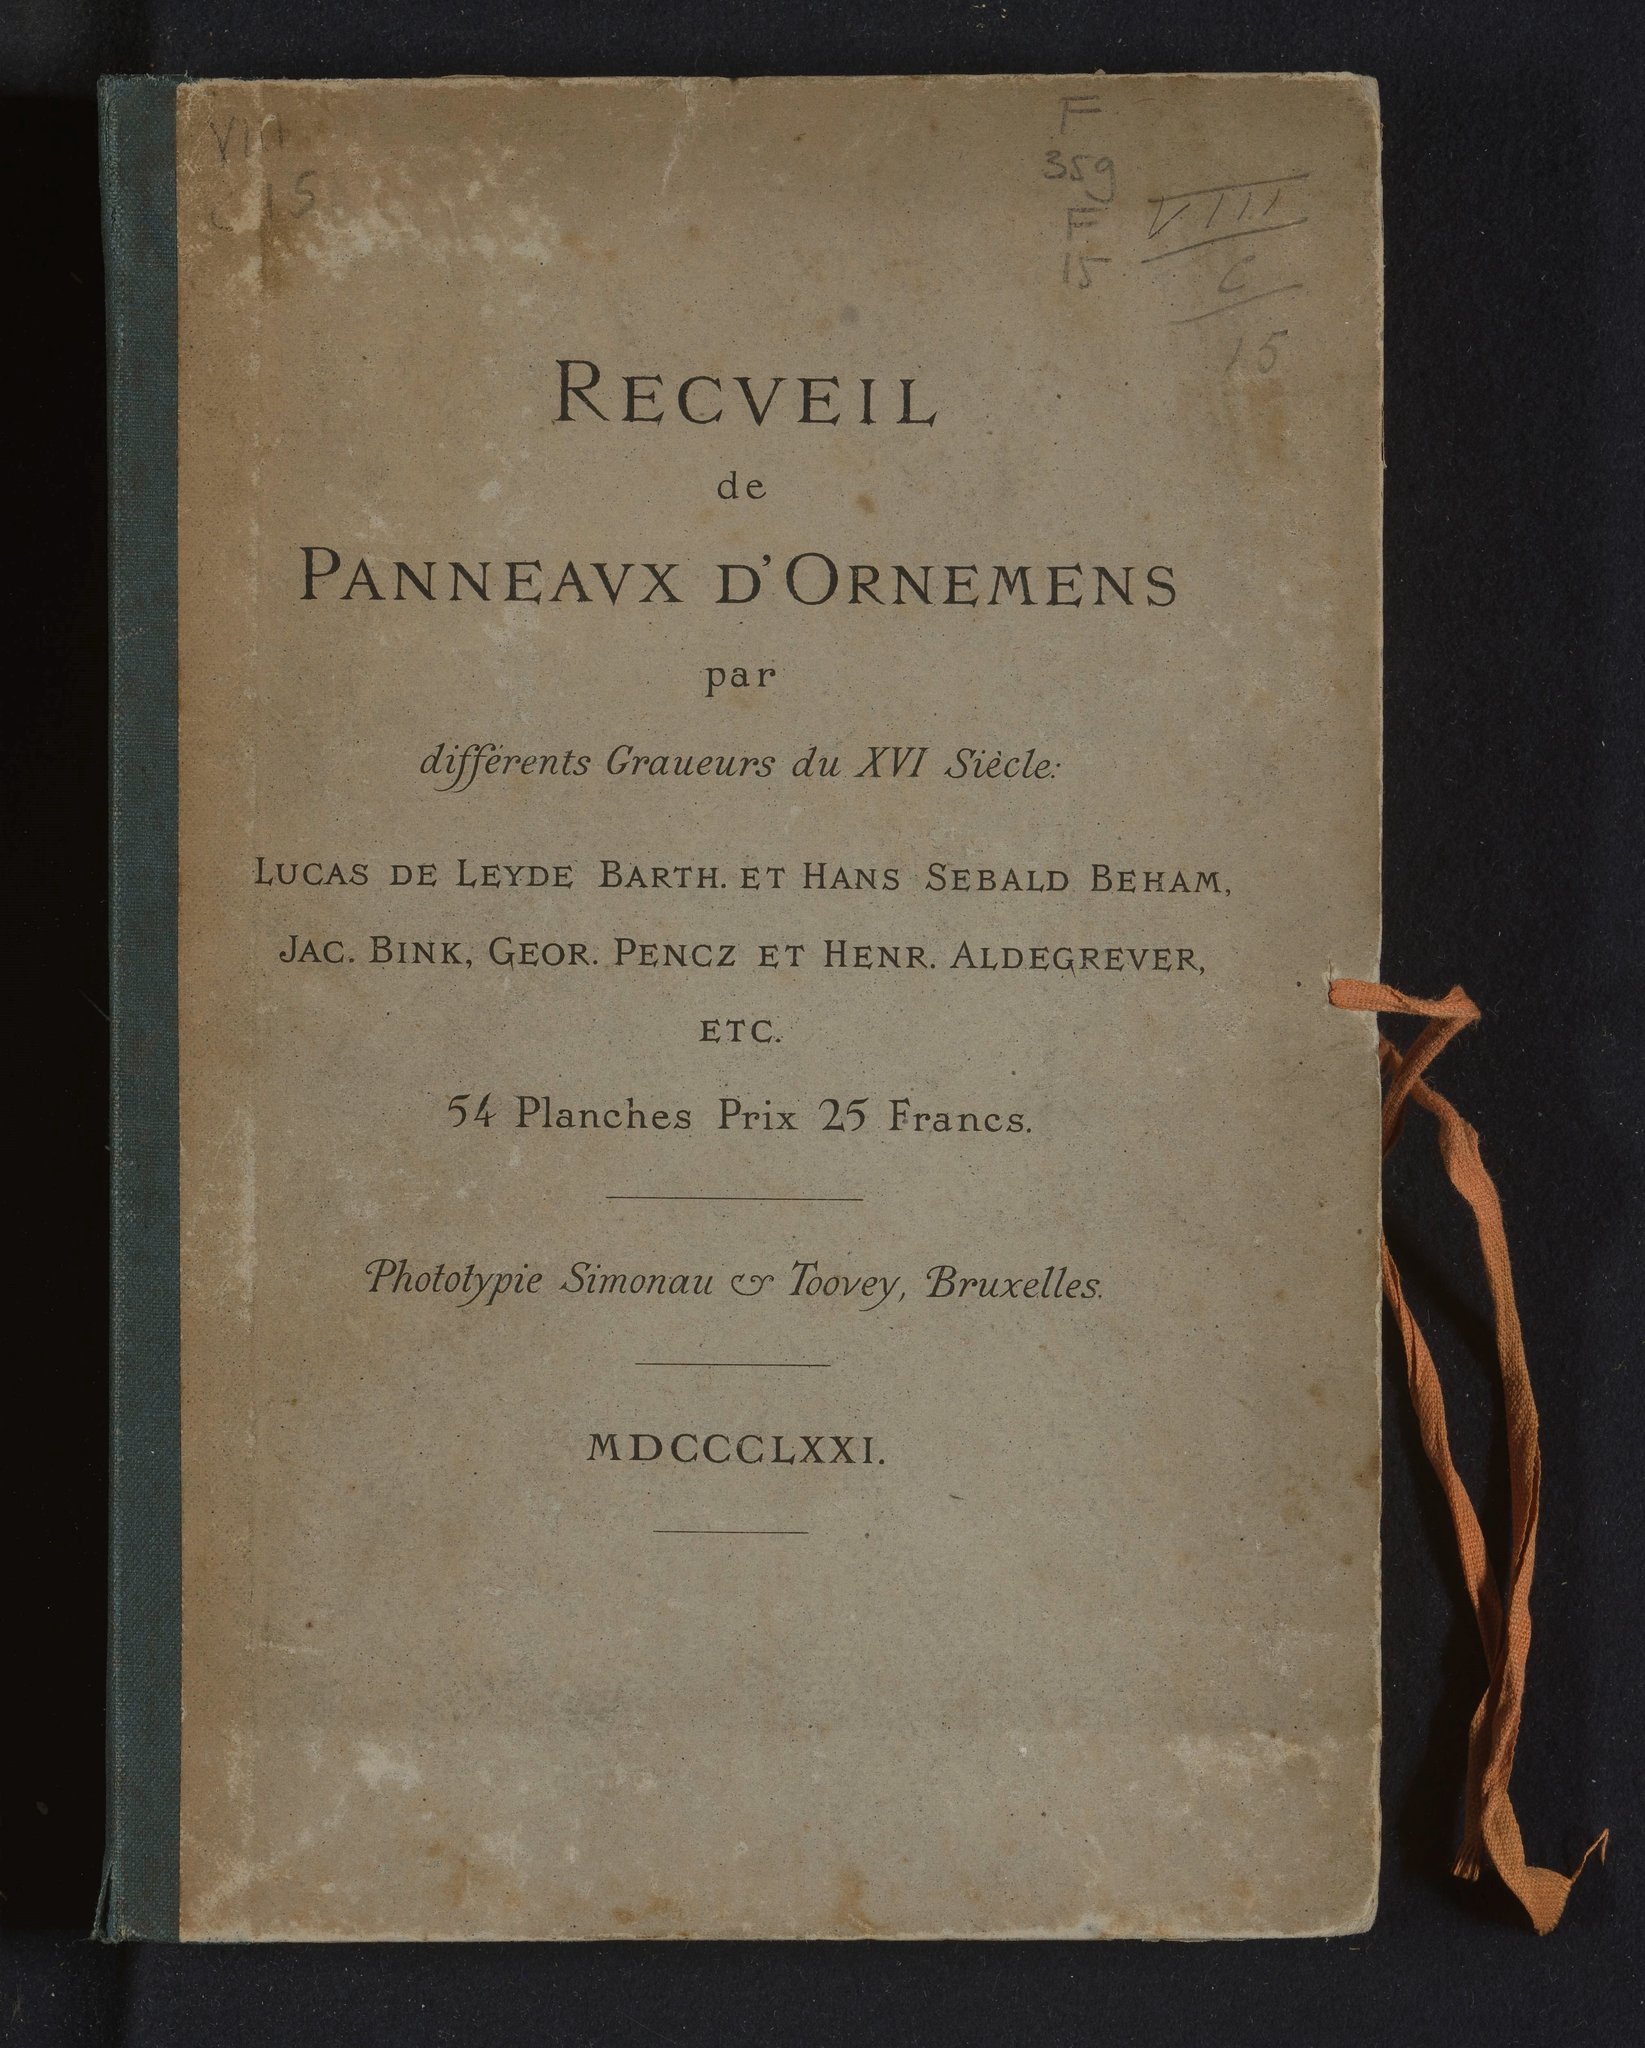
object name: wrapper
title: Recueil de panneaux d'ornements par différents graveurs du XVI siècle / Lucas de Leyde (...) [et al.]; phototypie Simonau & Toovey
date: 1871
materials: cardboard, linen, paper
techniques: woodburytype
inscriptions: bookplate: ‘EX. LIBRIS/ L. MONTHAYE/ BRUGES/ No 943’, annotation: ‘VIII/ C/ 15’, annotation: ‘35do’, annotation: ‘APR/ 1999’